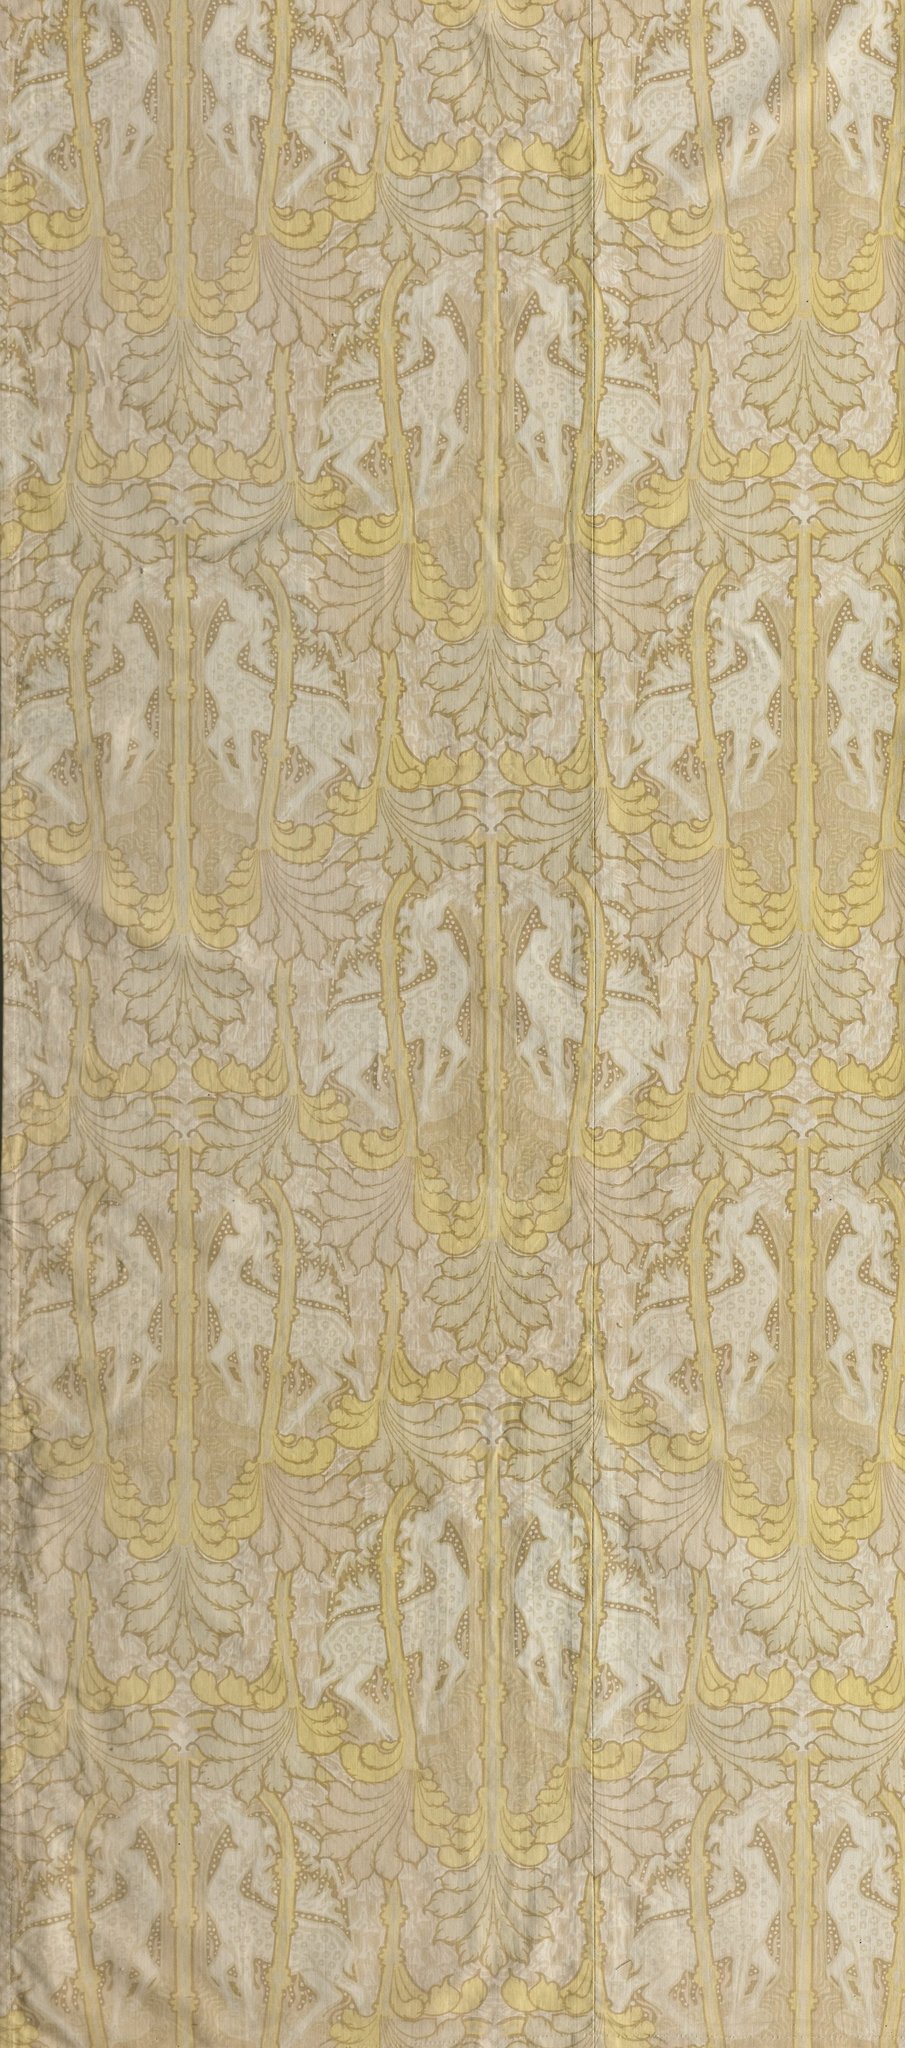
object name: overgordijn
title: Overgordijn van bedrukte cretonne met herten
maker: michiel duco crop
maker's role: designer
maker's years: 1862-1901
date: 1900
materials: linen, metal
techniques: printing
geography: helmond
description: Overgordijn van bedrukte cretonne met herten in gele en zachtbruine tinten op naturelkleurig fond. Aan de binnenzijde afgeboord met passement en voorzien van metalen ringen.